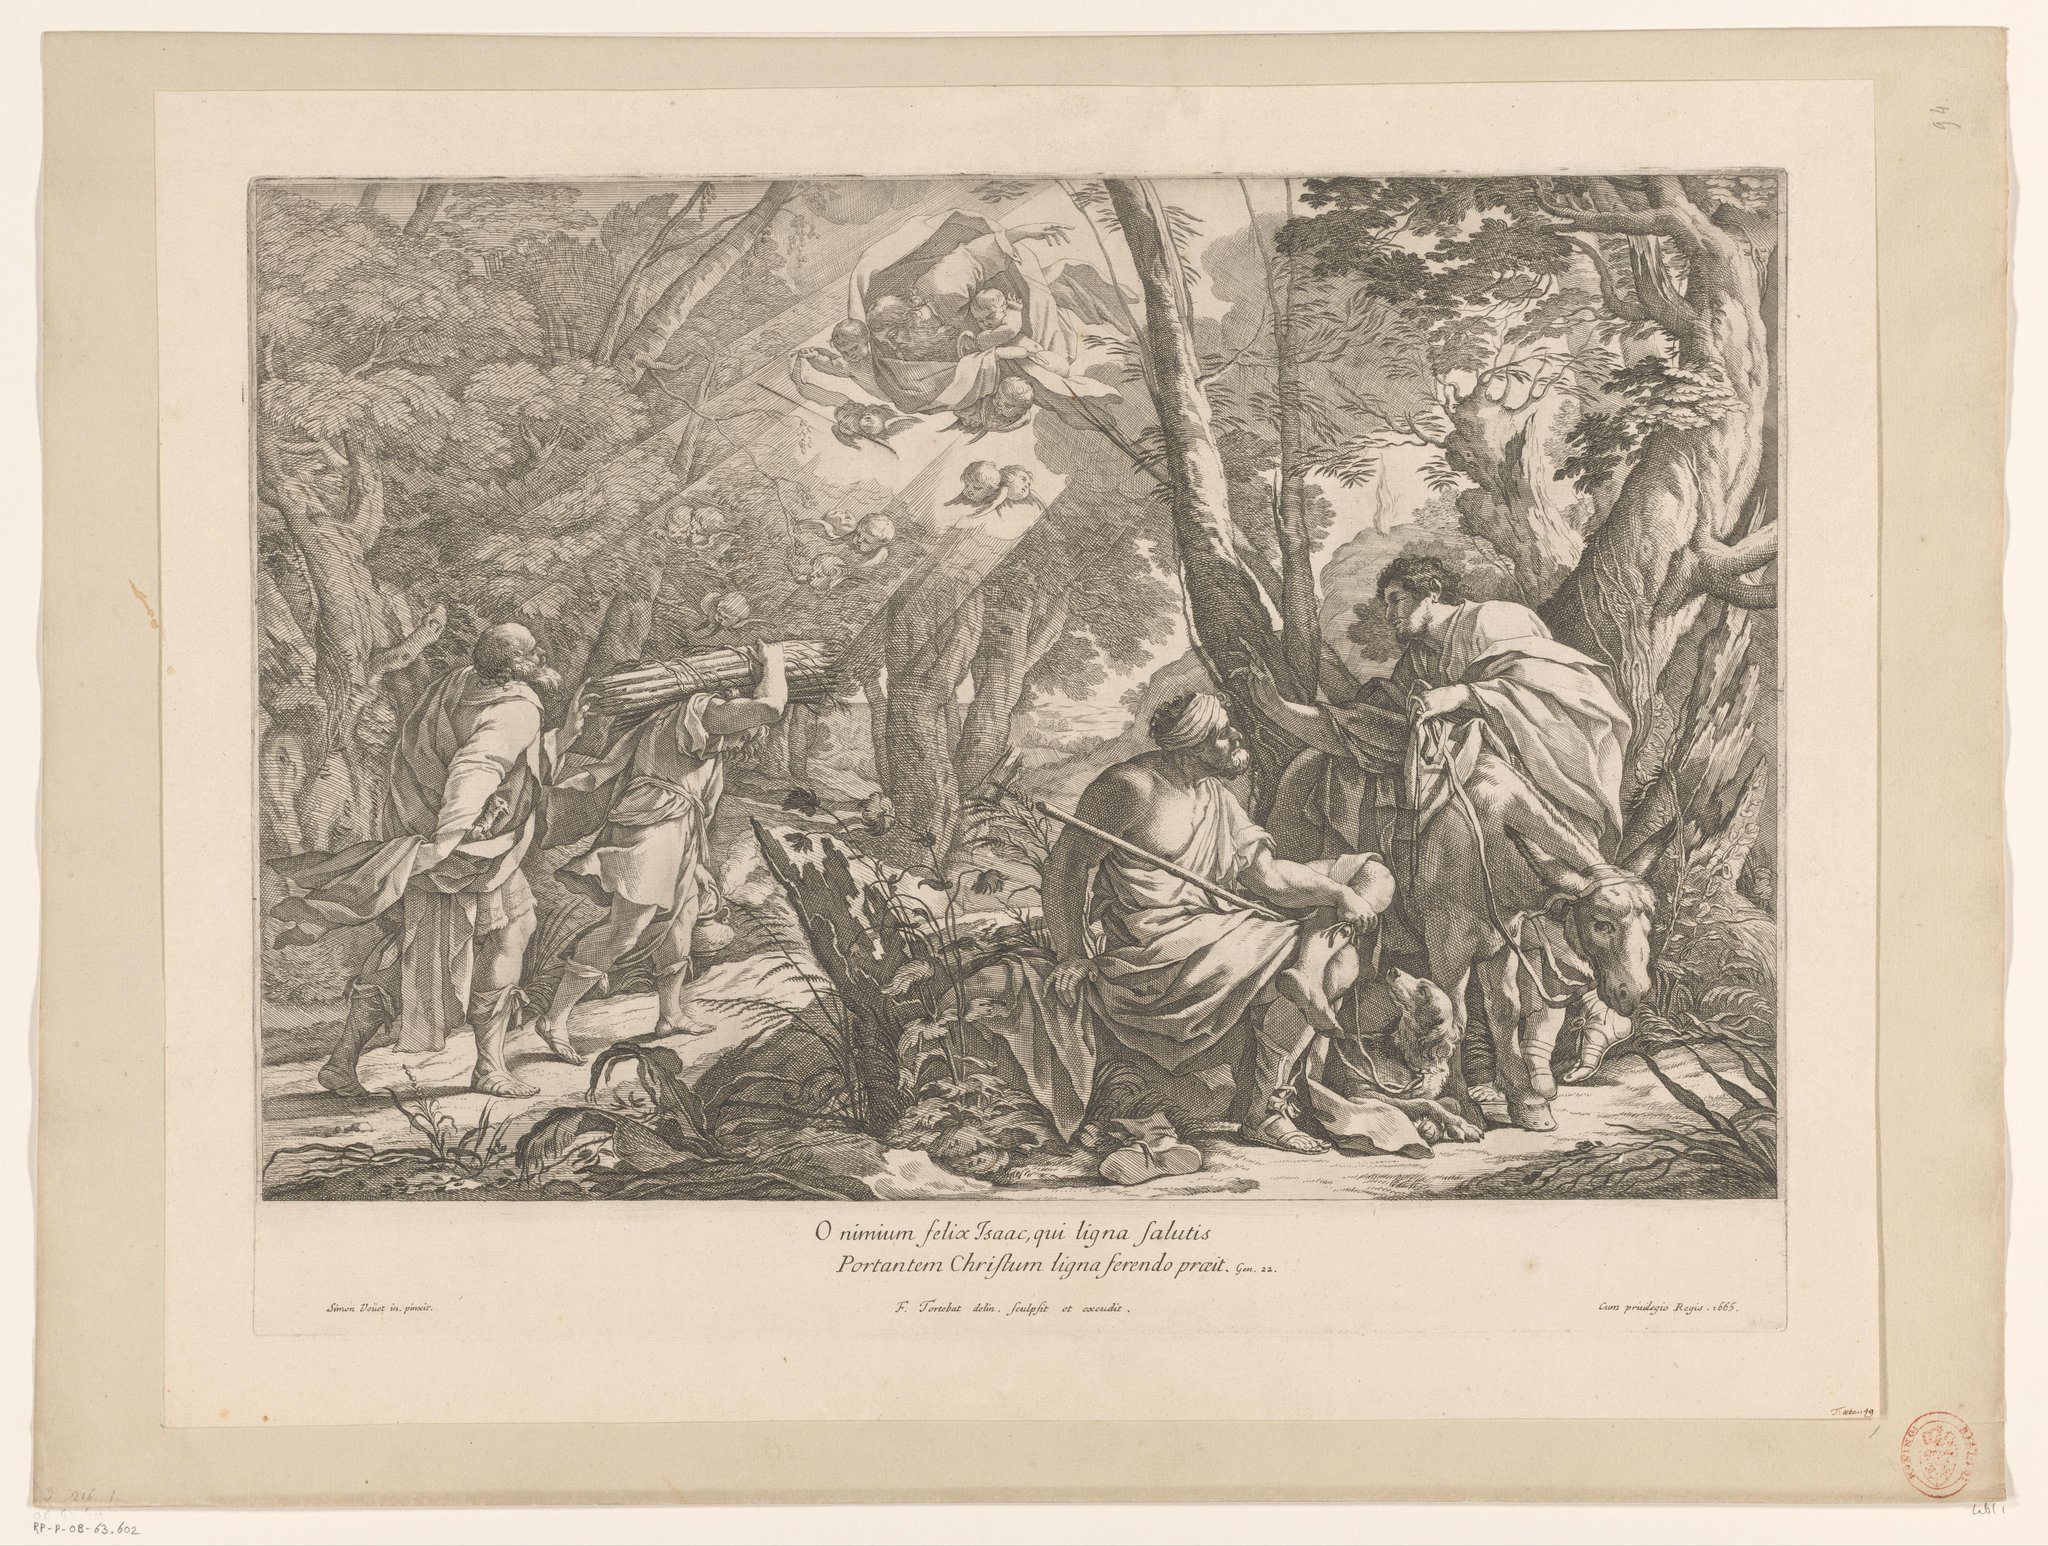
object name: print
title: Abraham en Isaak op weg naar de offerplaats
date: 1665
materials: paper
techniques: etching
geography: france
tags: the servants are left behind while abraham and isaac (usually carrying wood) climb the mountain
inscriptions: collector's mark: Lugt 240, inscription: ‘T: aeta: 49’